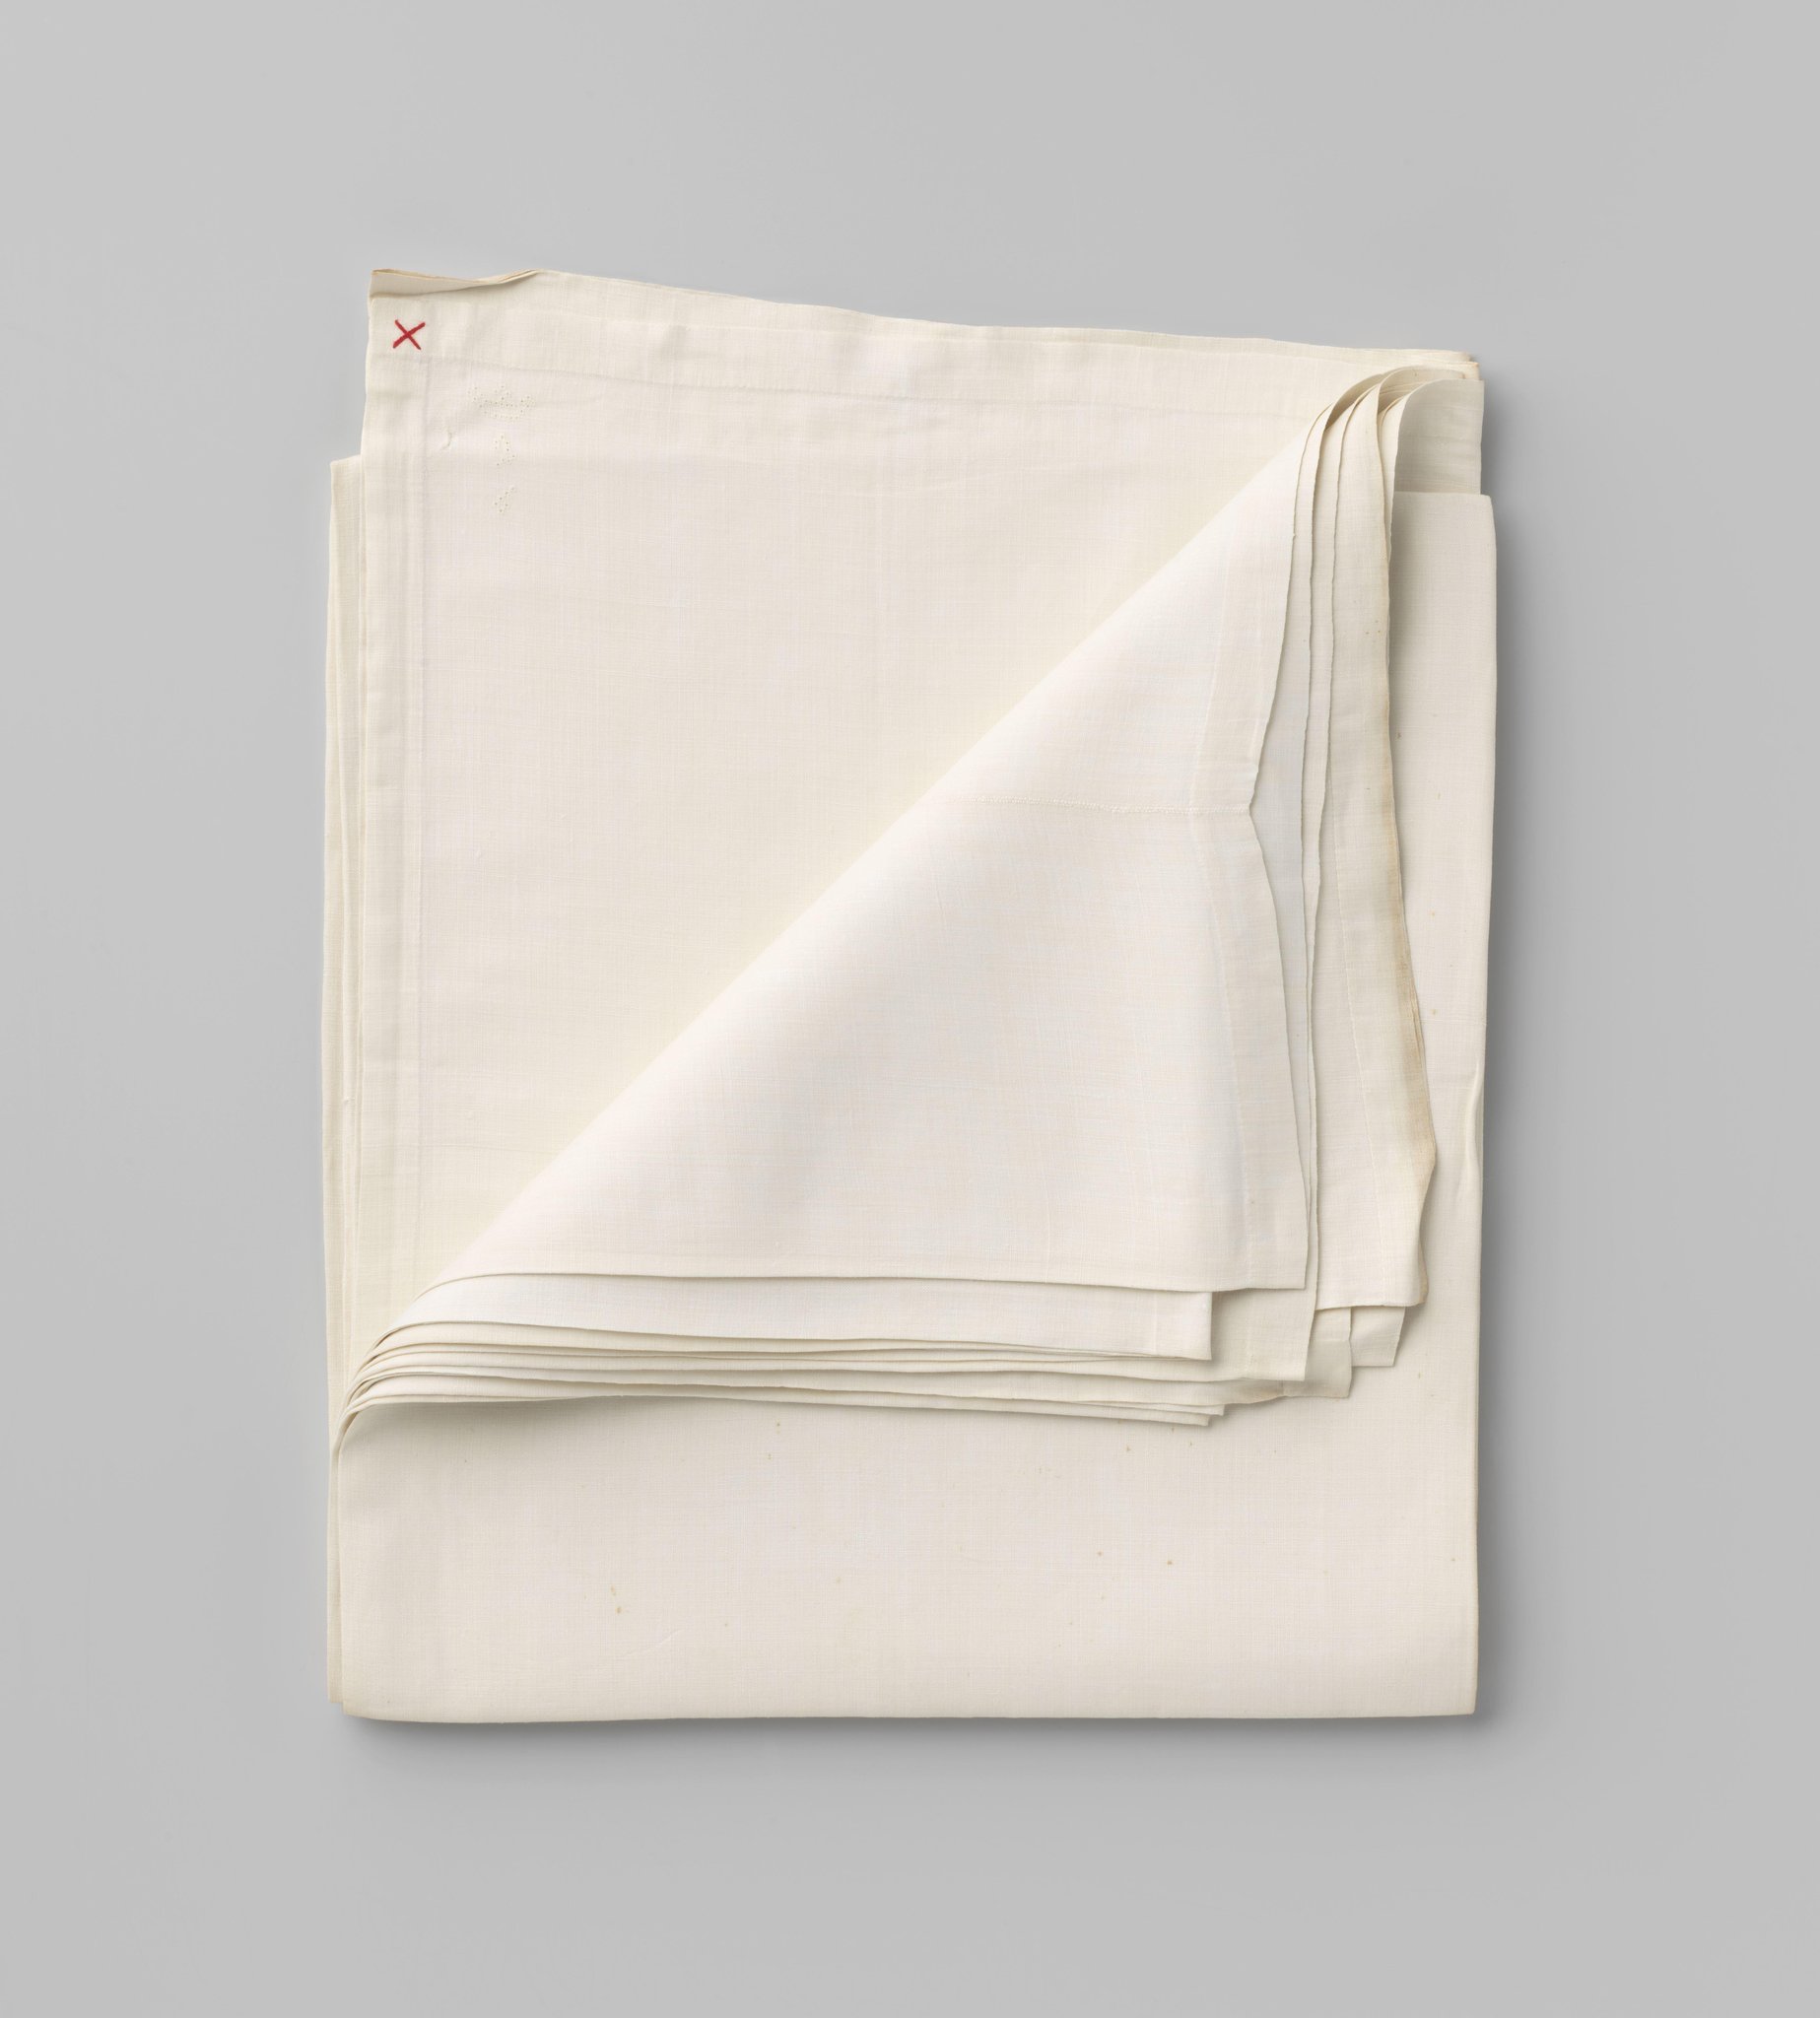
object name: beddenlaken, laken object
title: Laken. Merk: kroon G6 en jaartal 1766.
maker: Anonymous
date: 1766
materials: linen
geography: northern netherlands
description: Laken van wit linnen, merk kroon G6 en jaartal 1766